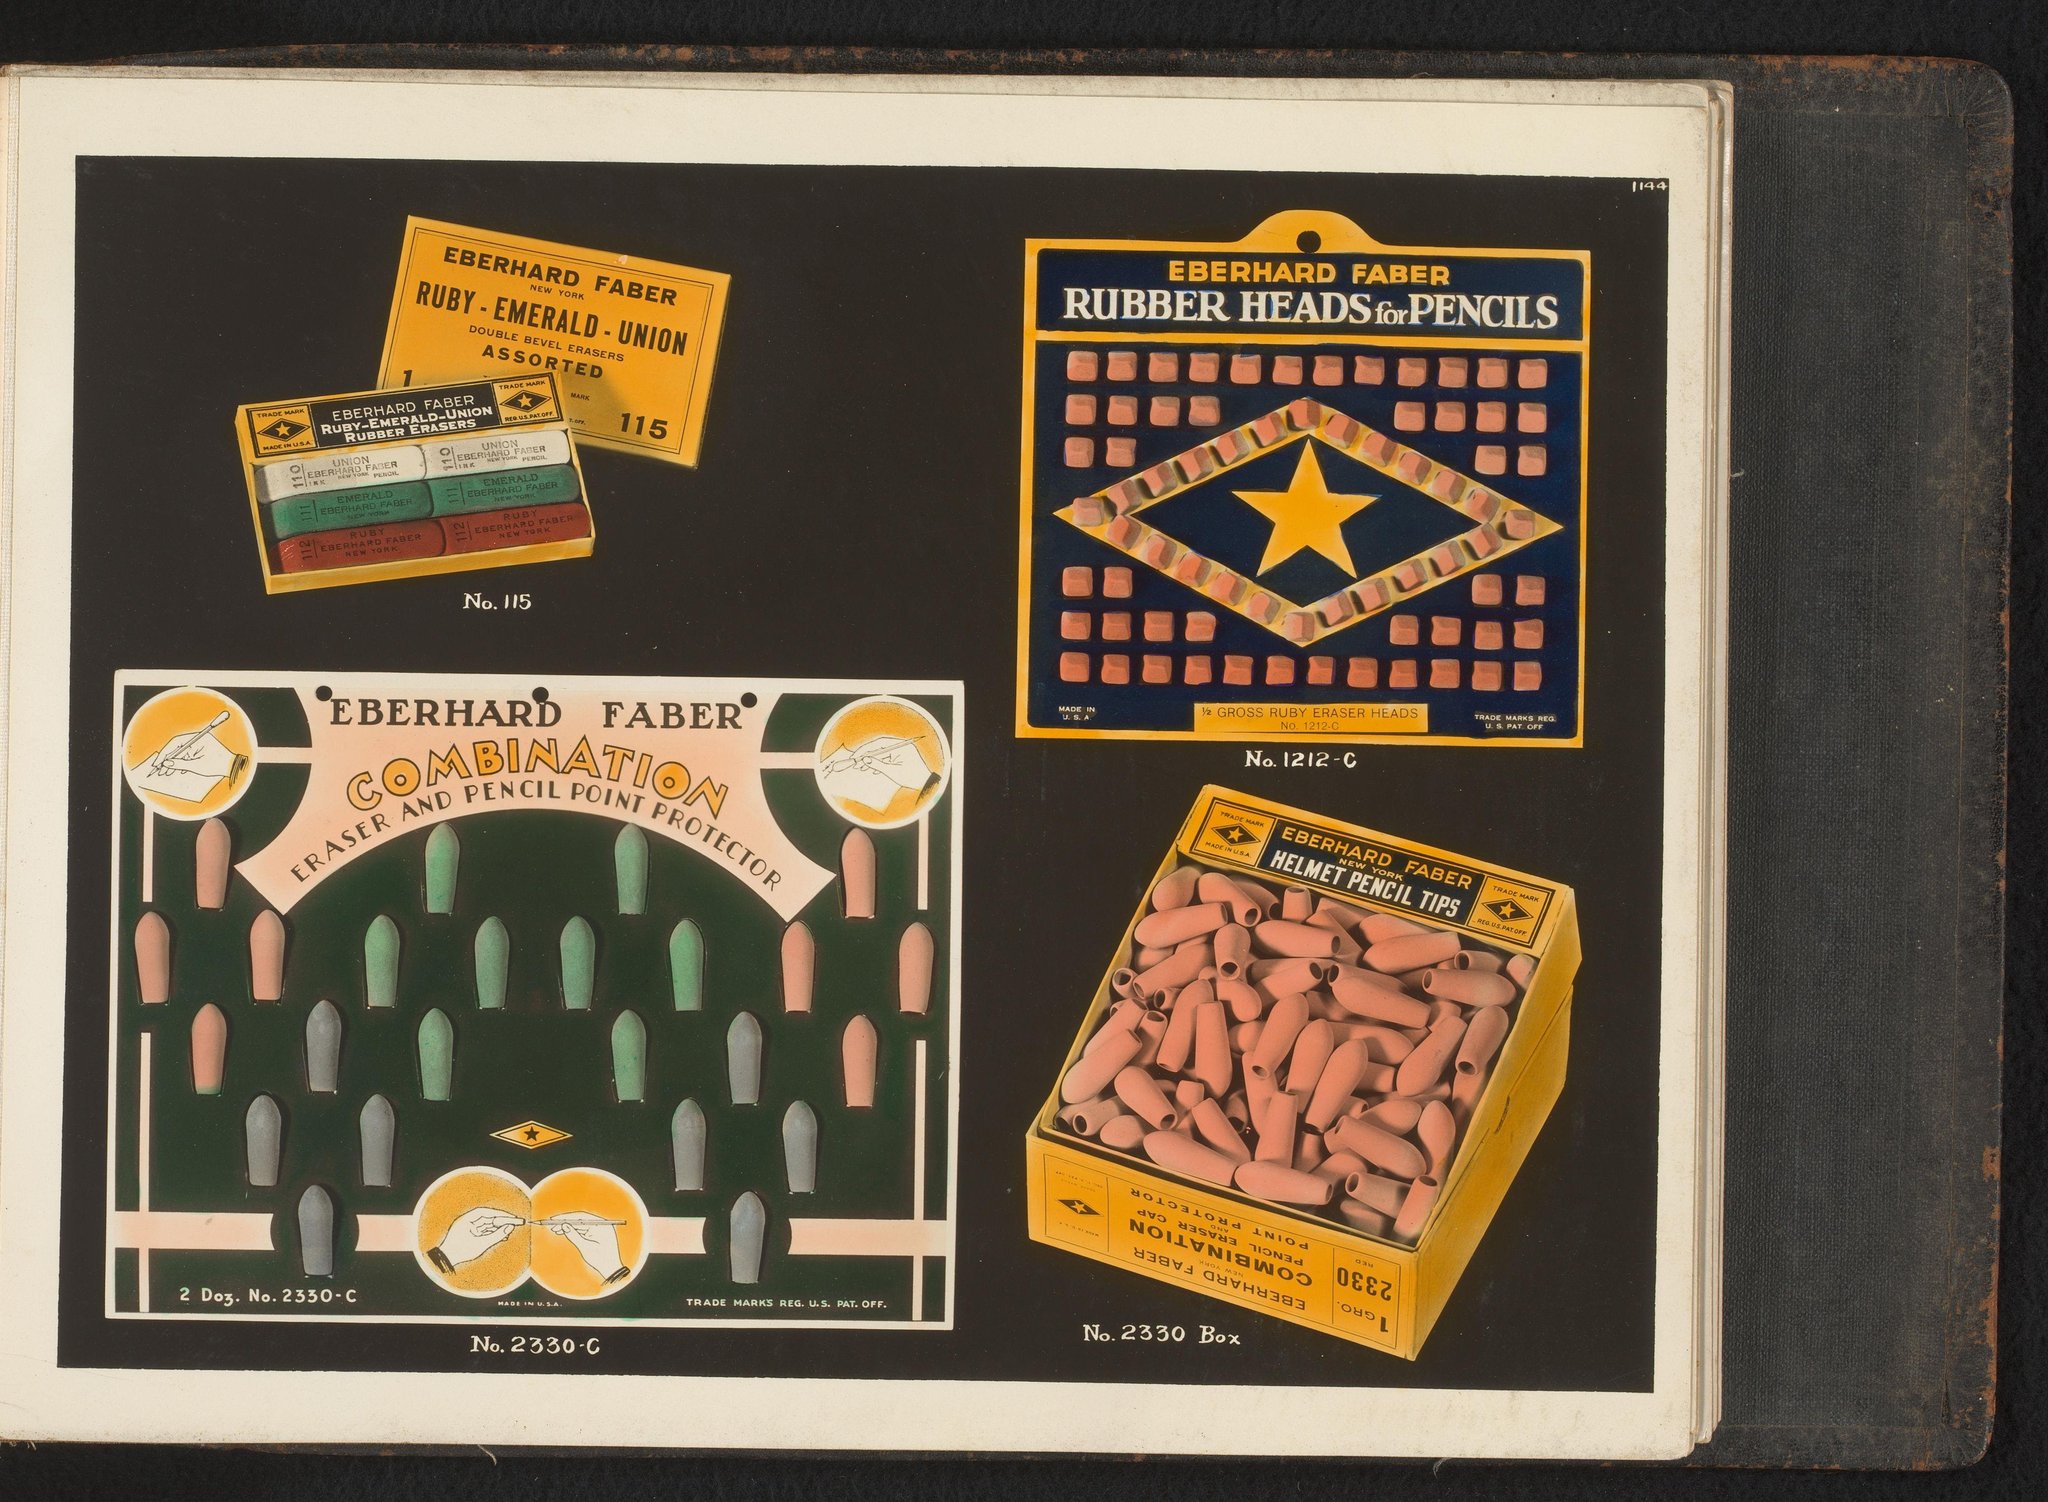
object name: album leaf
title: Gummen van Eberhard Faber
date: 1915-1935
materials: paper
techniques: gelatin silver print, hand coloring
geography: springfield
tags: writing tools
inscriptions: number: ‘1144’, stamp: ‘Paramount/ Commercial Studios/ 145 Chestnut St./ Springfield - Mass.’